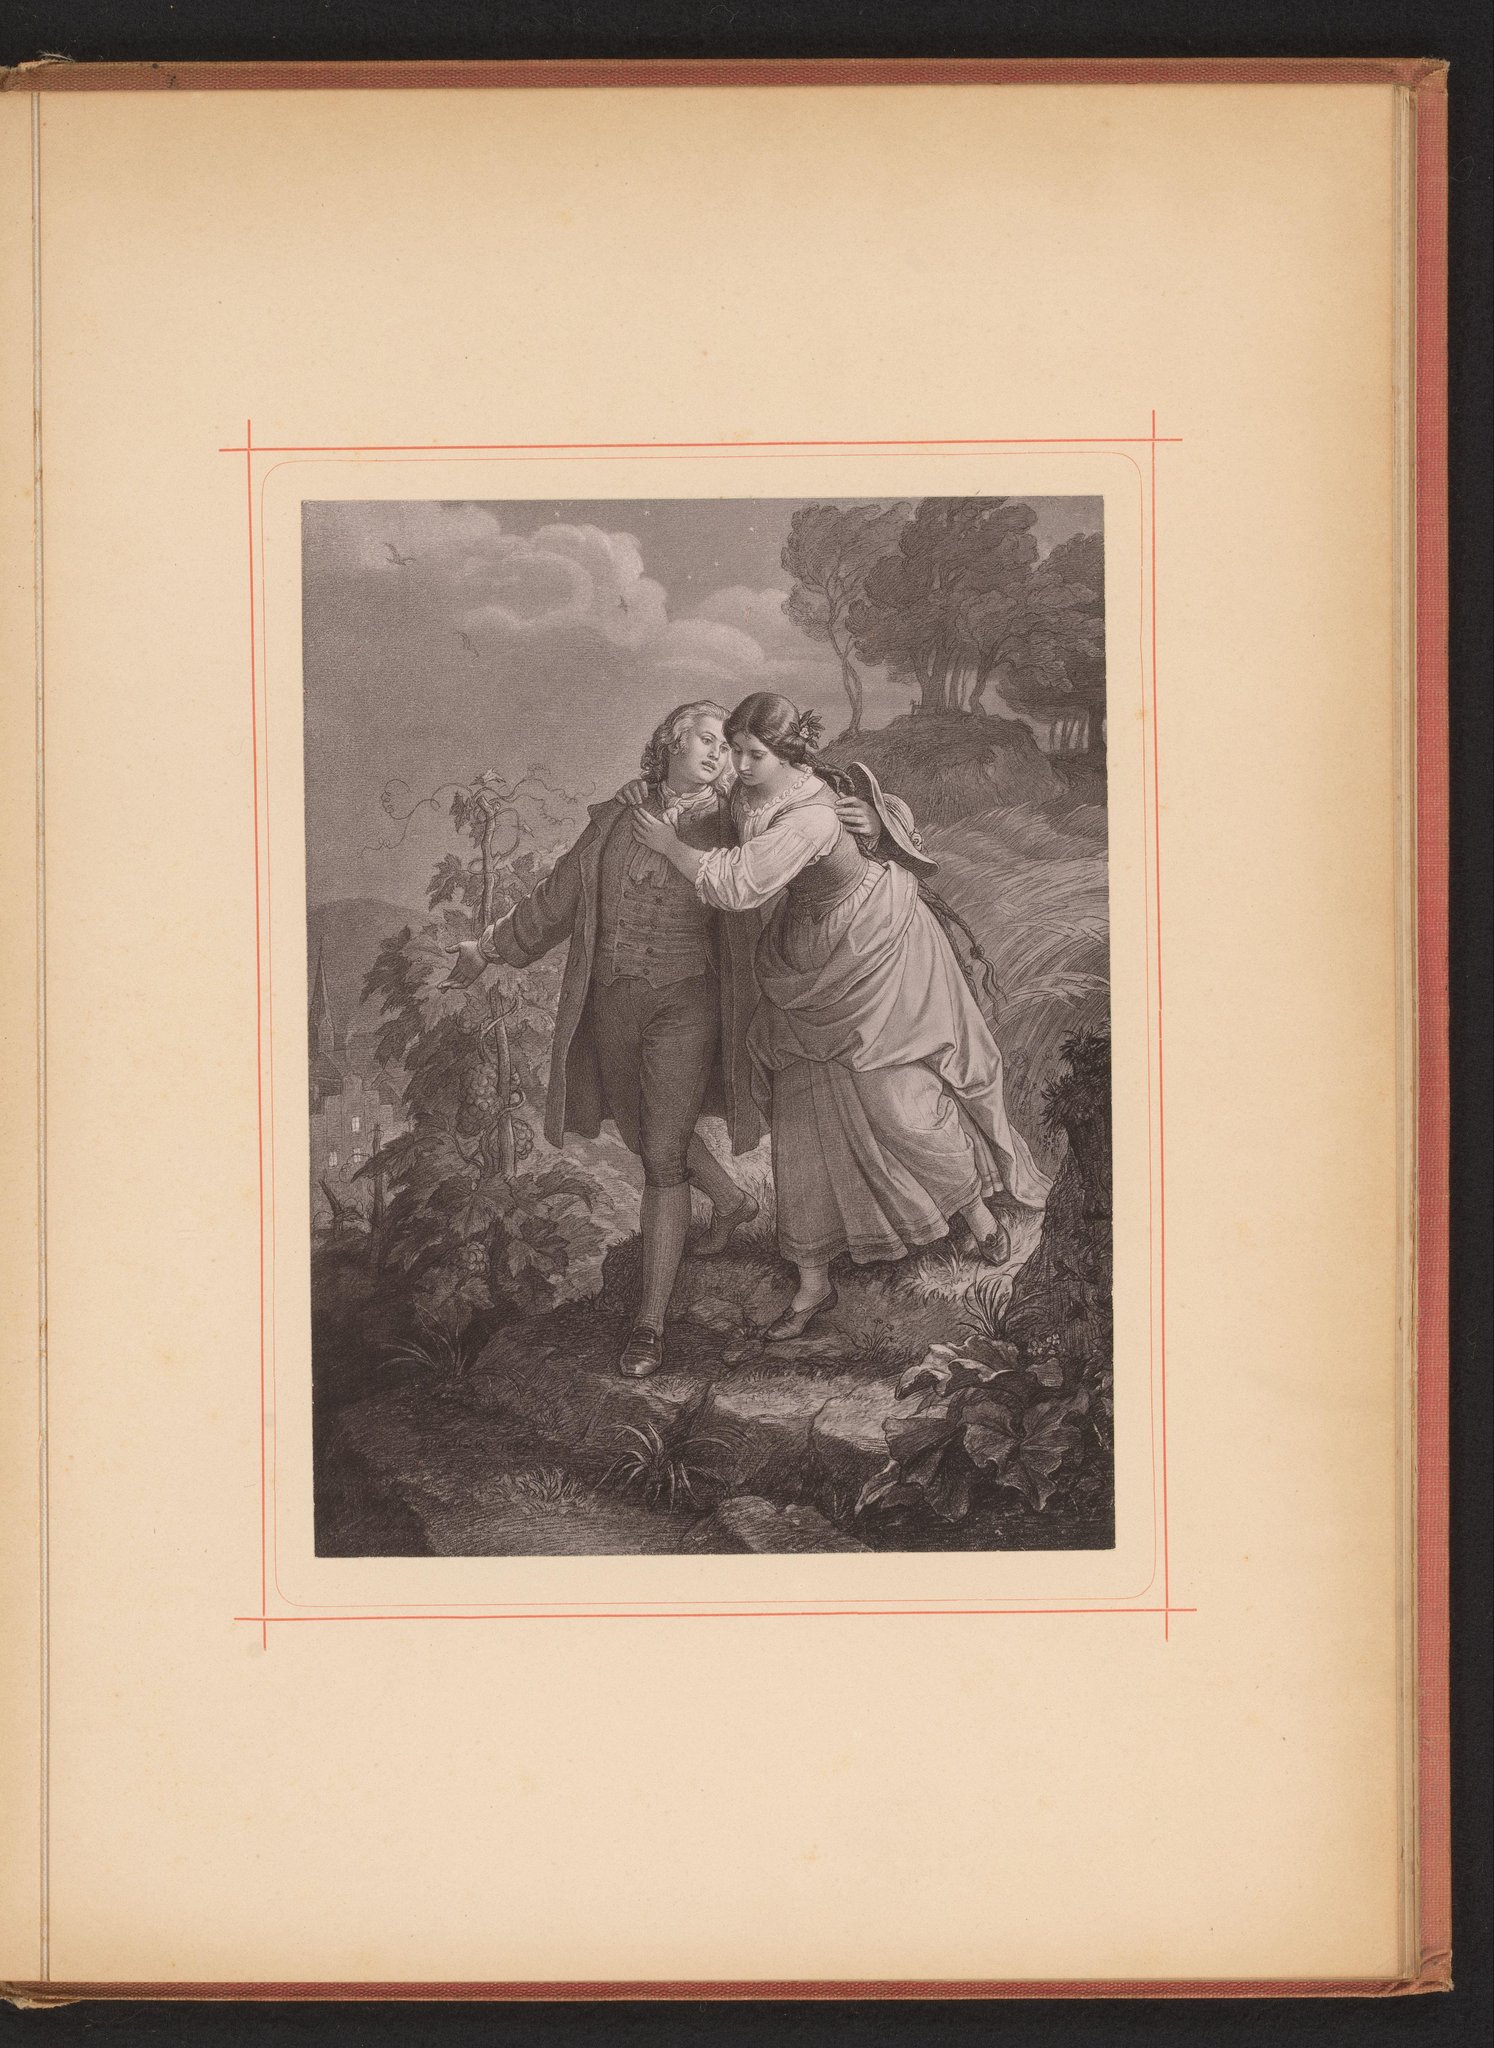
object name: photomechanical print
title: Reproductie van een tekening, voorstellende Herman en Dorothea die huiswaarts keren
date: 1880-1885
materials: paper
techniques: photograph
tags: literary characters and objects, couple of lovers, painting, drawing and the graphic arts